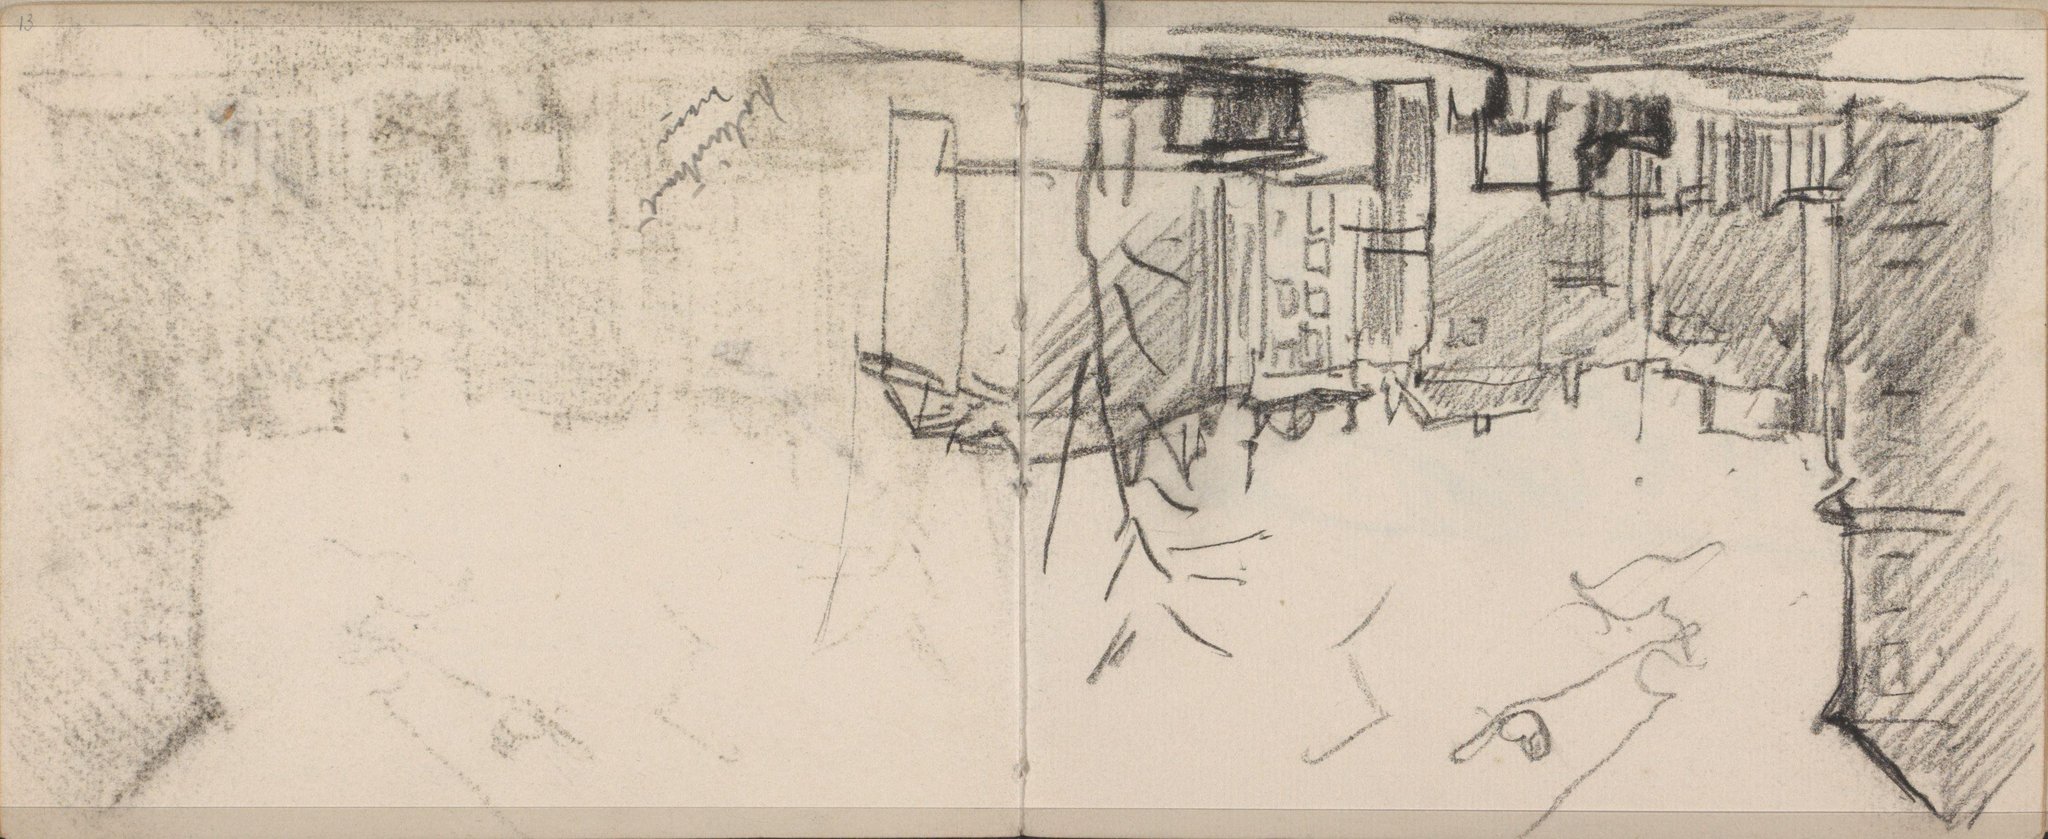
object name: sketchbook leaf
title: Gezicht op de Paleisstraat te Amsterdam met het Koninklijk Paleis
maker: george hendrik breitner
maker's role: draughtsman, painter, print maker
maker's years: 1857-1923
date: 1886-1891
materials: chalk, paper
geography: amsterdam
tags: urban housing, street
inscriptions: annotation: ‘Paleisstraat/ [...]’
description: Pagina 13 en pagina 14 uit een schetsboek met 32 bladen.